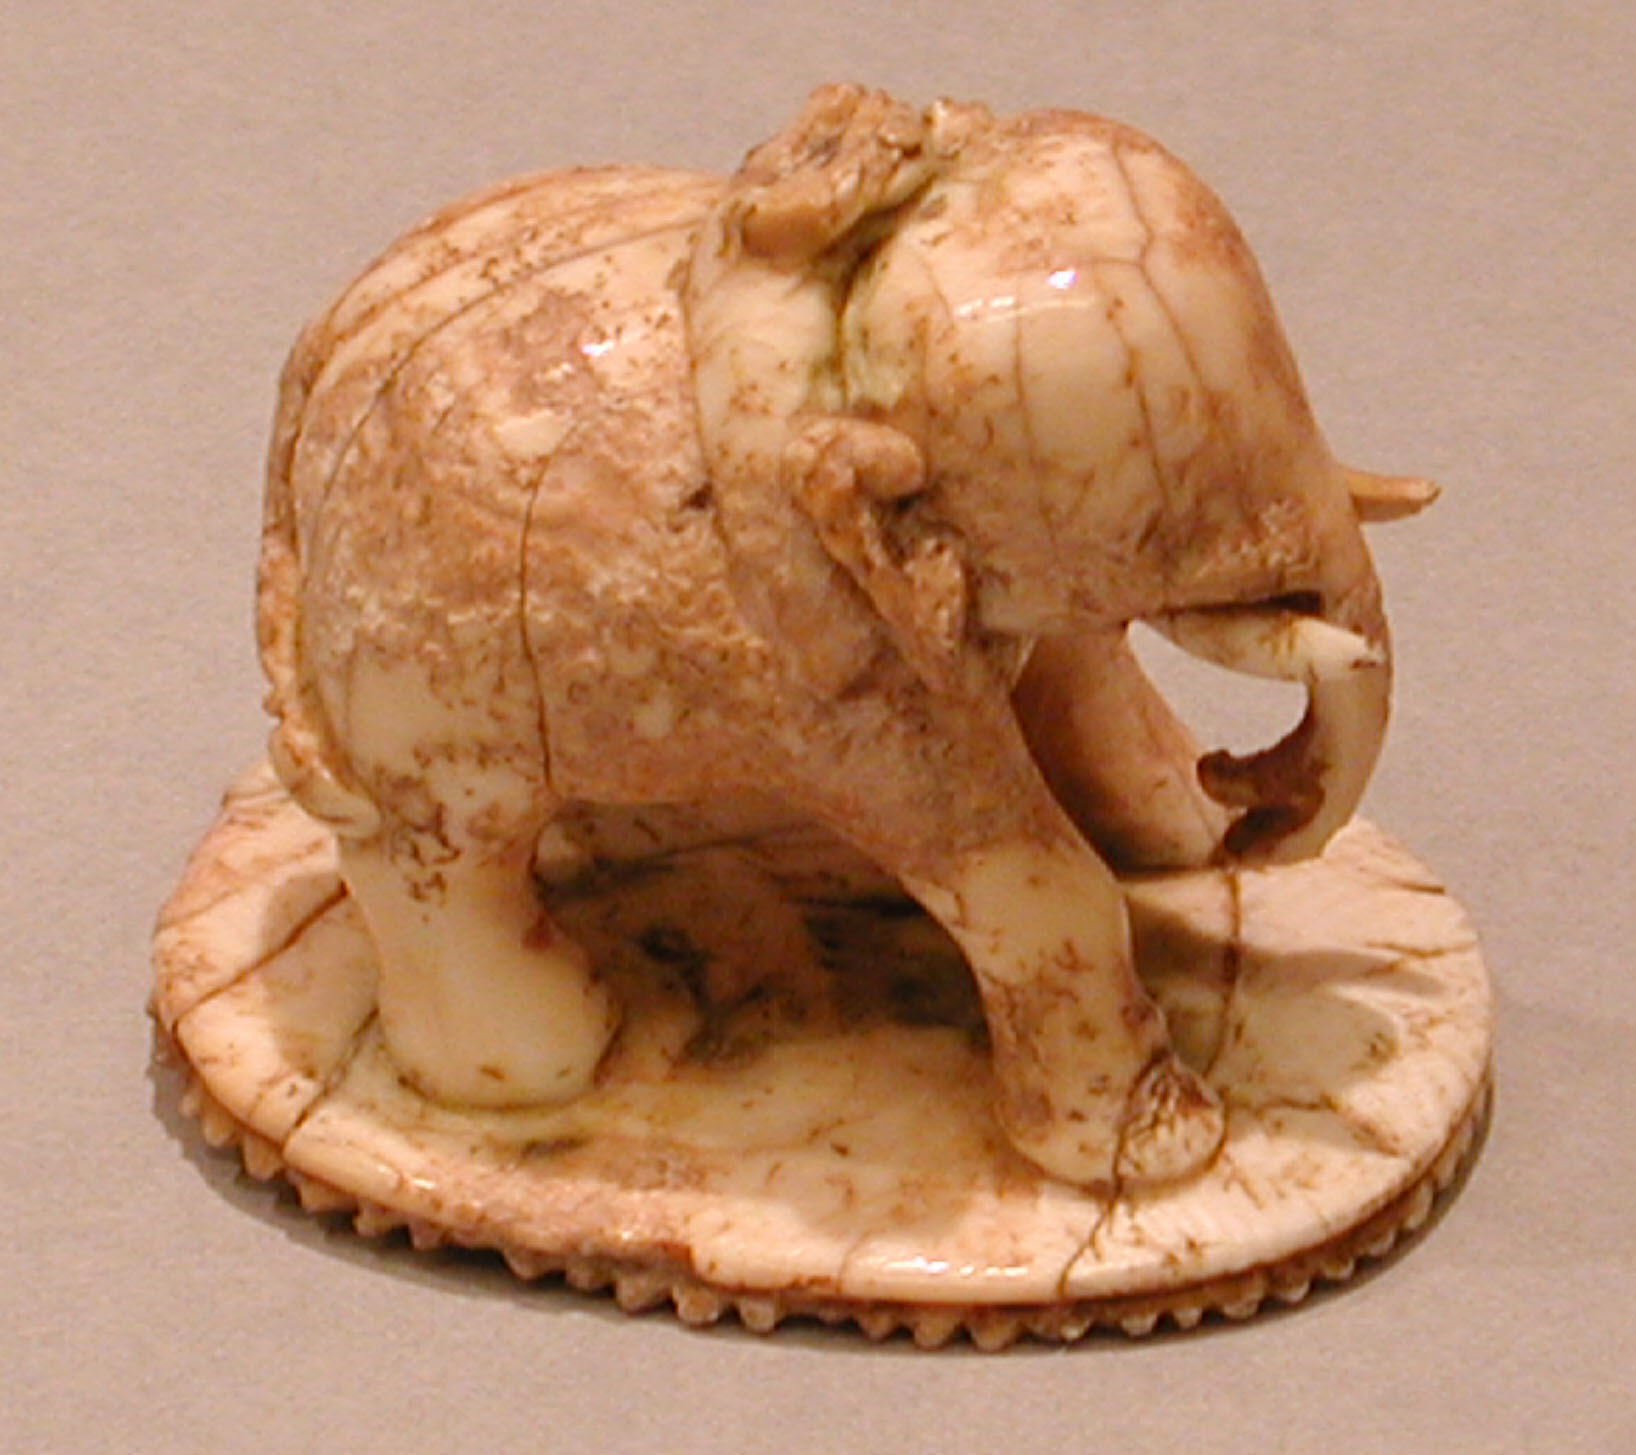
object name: chess piece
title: Chess Piece, Bishop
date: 1667-1733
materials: ivory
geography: india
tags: chess,elephants